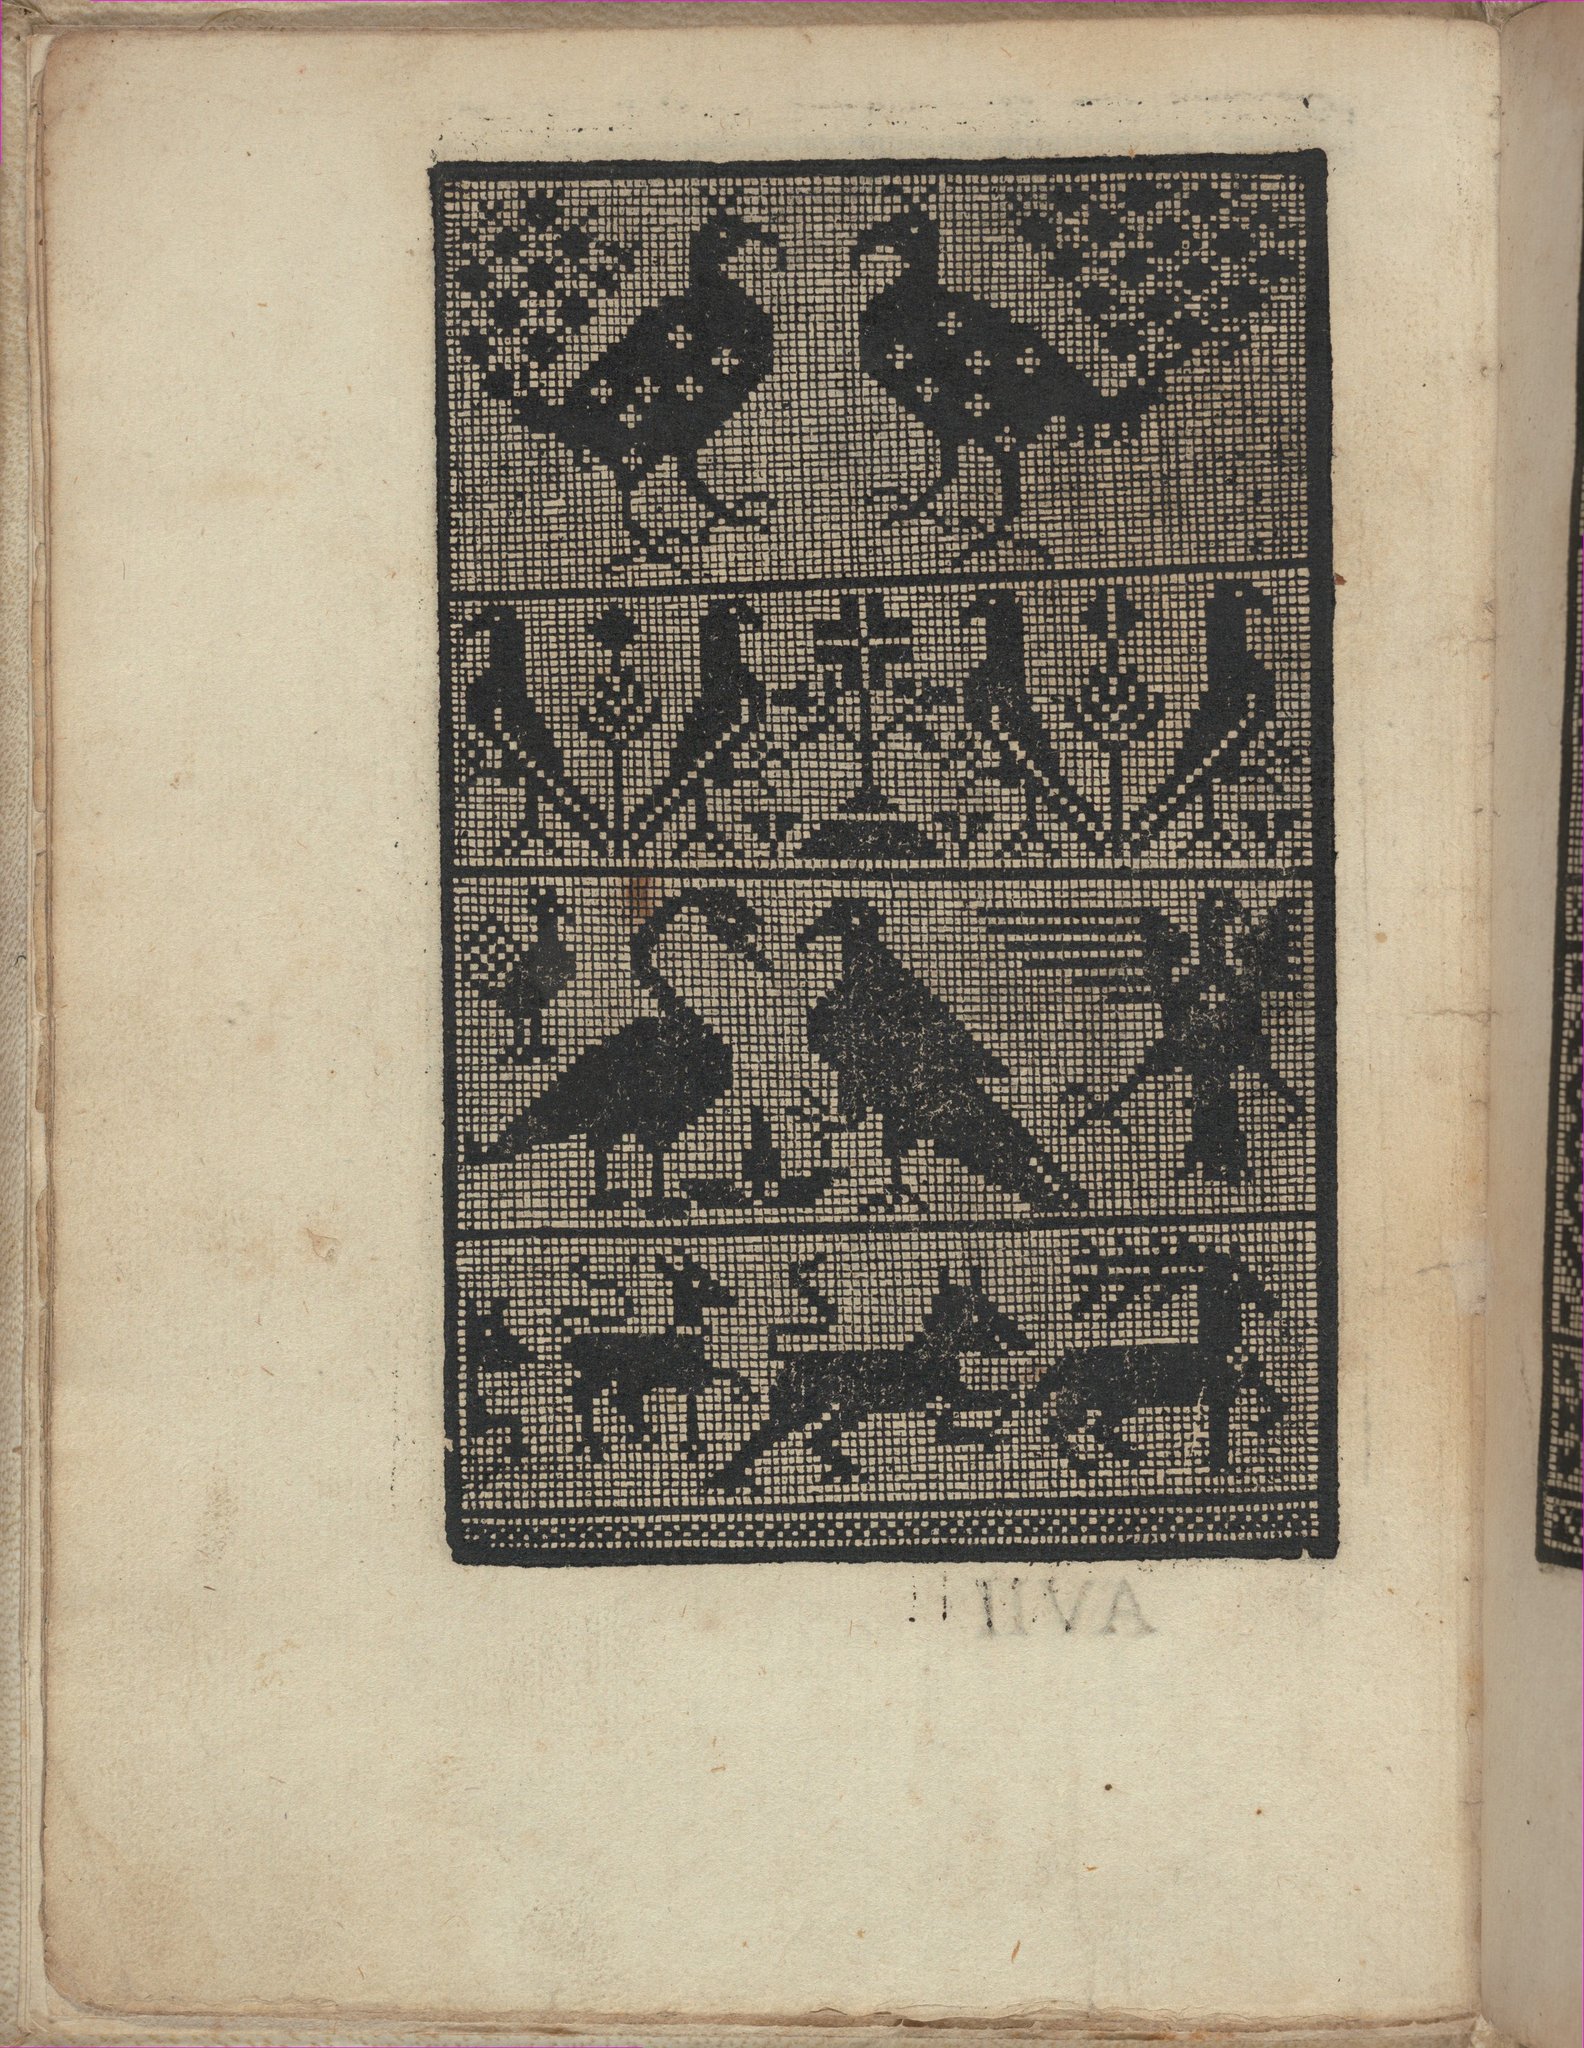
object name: book print ornament architecture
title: Esemplario di Lauori..., page 5 (recto)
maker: giovanni andrea vavassore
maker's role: publisher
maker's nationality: italian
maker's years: 1530-1573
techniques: woodcut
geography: venice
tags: birds